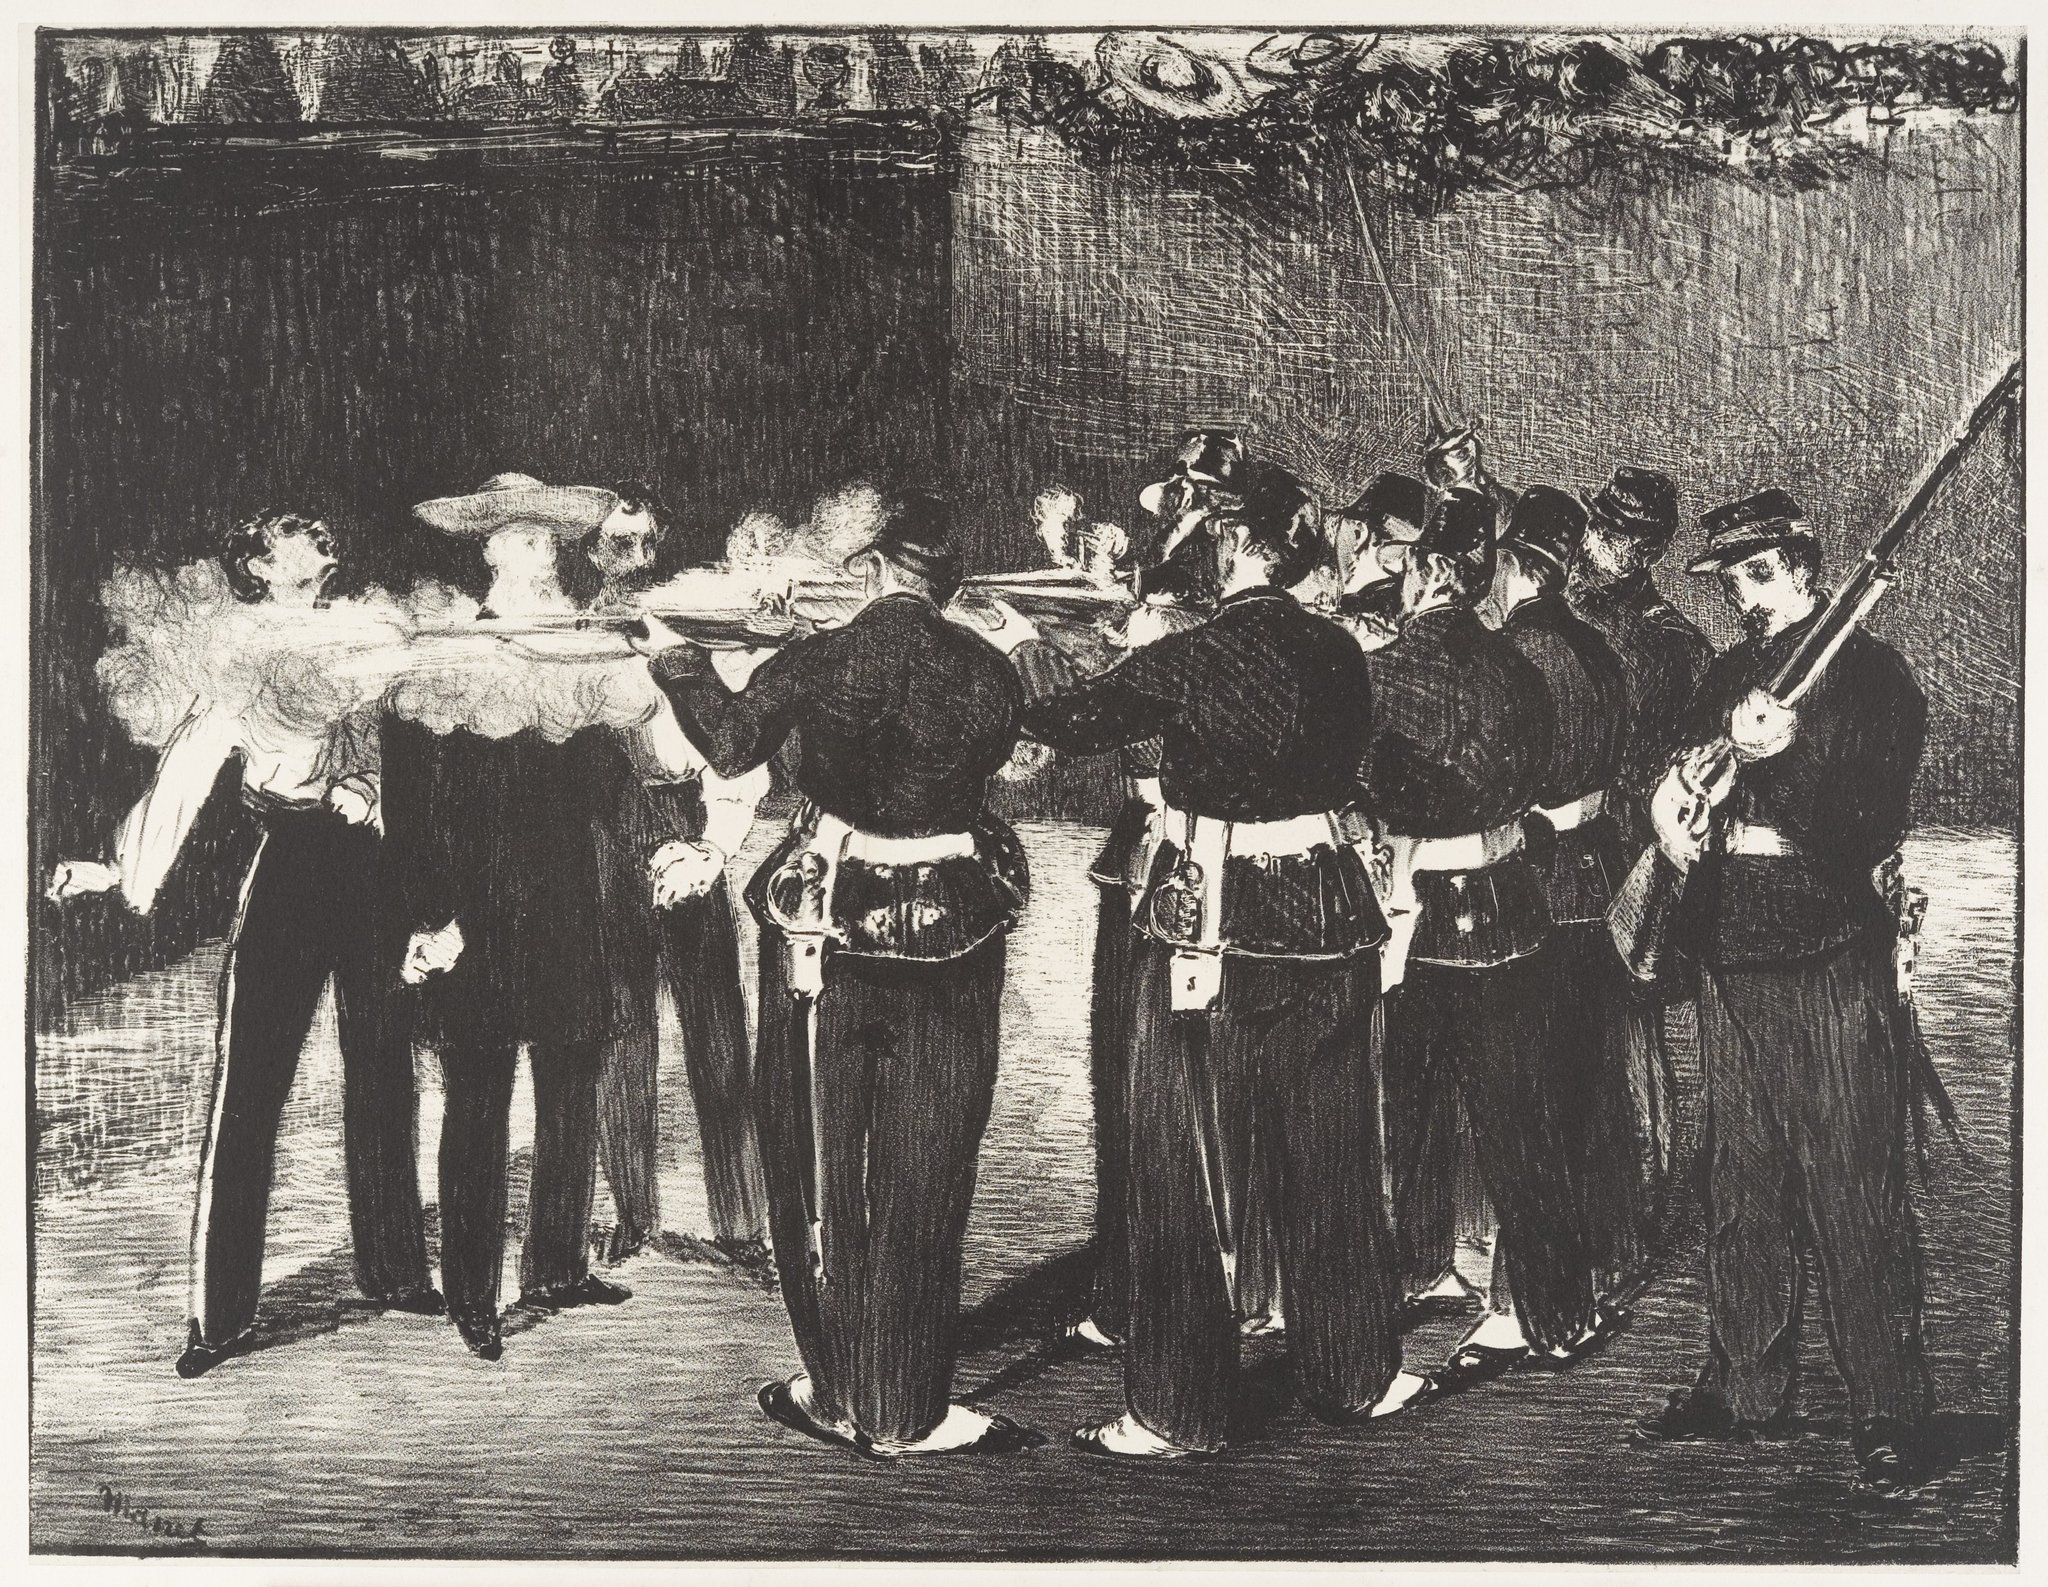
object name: print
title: The Execution of Maximilian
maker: édouard manet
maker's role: artist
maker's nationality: french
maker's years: 1832-1883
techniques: printmaking, lithograph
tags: soldiers,firearms,swords,men,execution